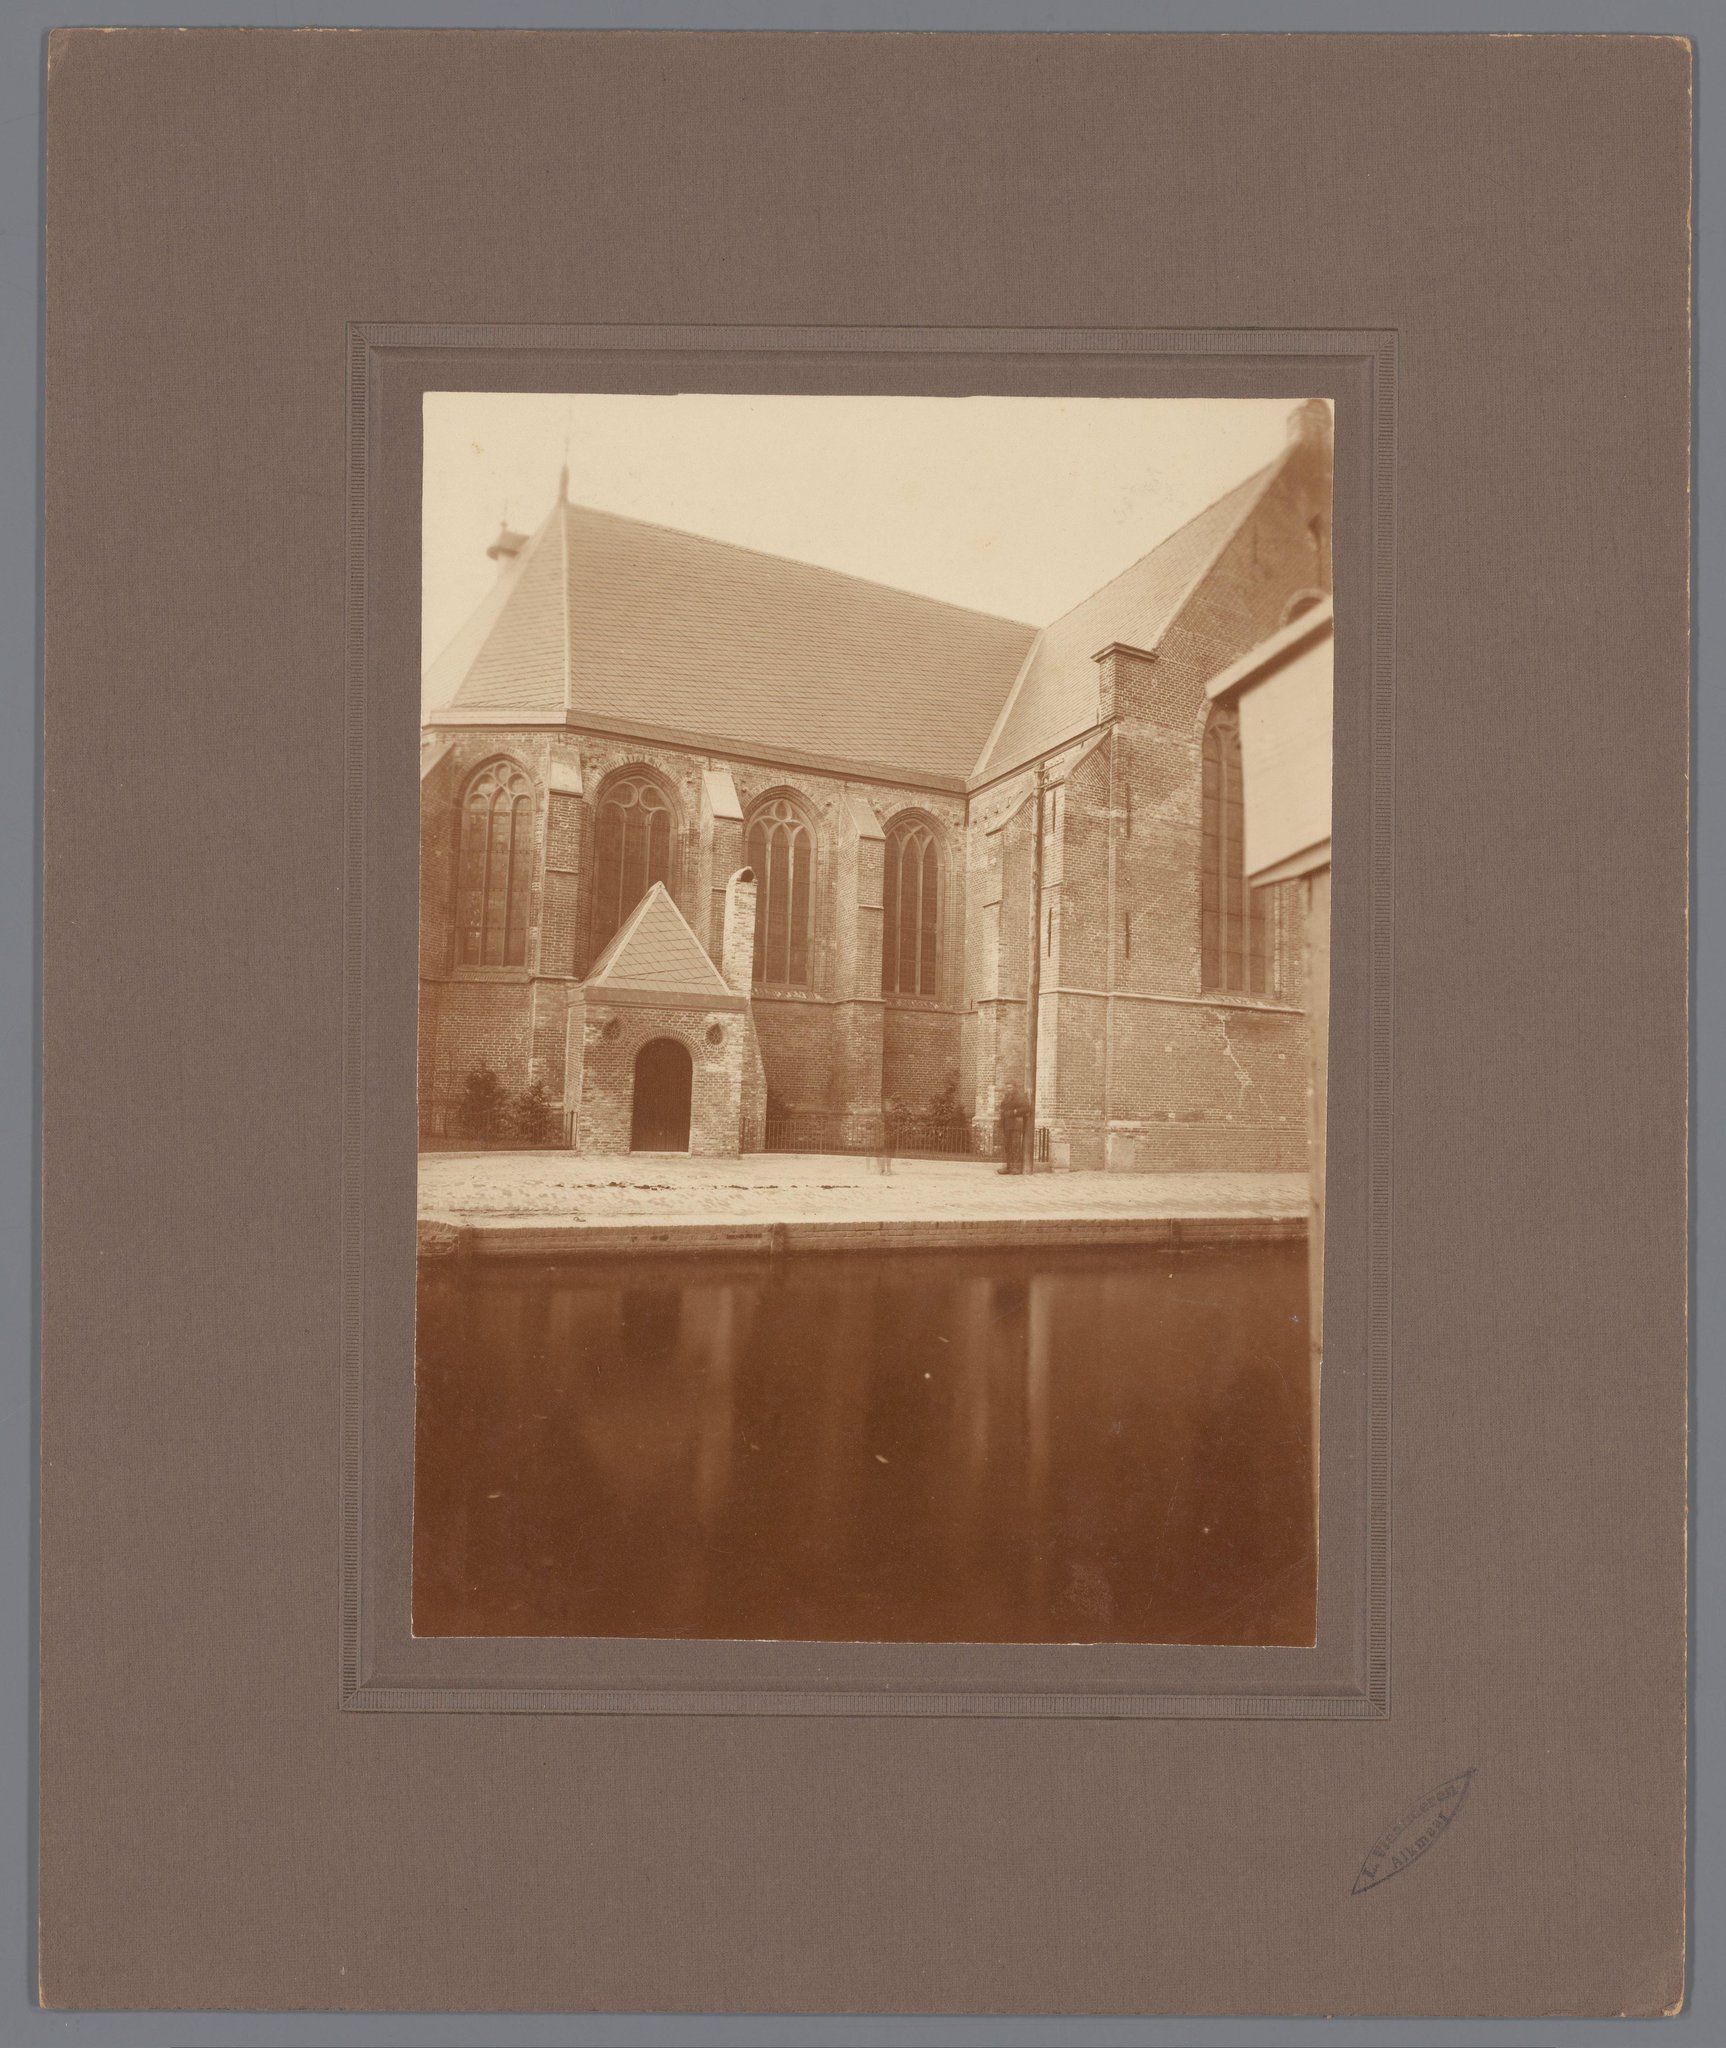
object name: photograph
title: Aanzicht op Nederlands Hervormde Kerk in De Rijp, Noord-Holland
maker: leonard vlaanderen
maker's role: fotograaf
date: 1923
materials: cardboard, photographic support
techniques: gelatin silver print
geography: alkmaar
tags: de rijp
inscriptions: stamp: ‘L.Vlaanderen//Alkmaar’, annotation: ‘De Rijp 1923’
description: Aanzicht op Nederlands Hervormde Kerk in De Rijp, Noord-Holland, zijbeuk en schip. Water ervoor, waarin weerspiegeling van gebouw.